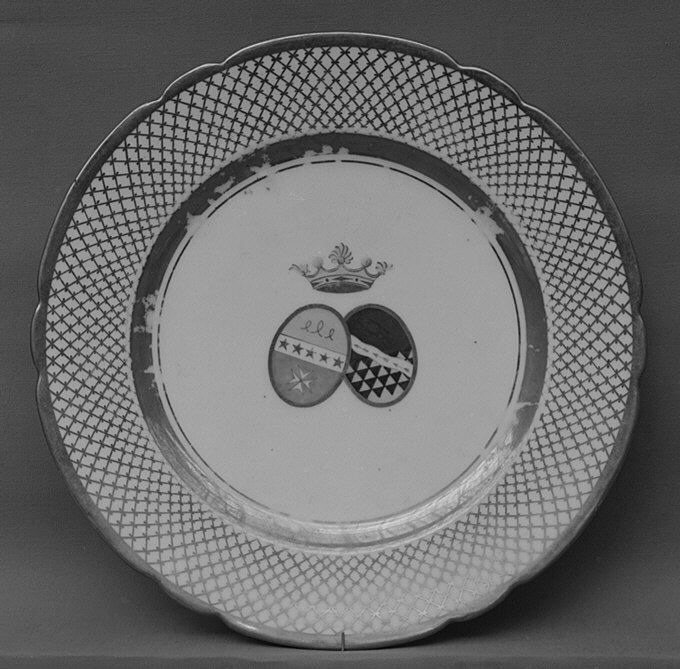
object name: plate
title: Dinner plate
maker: couderc, couderc-bucher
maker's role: maker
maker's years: 1844-1850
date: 1845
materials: hard paste porcelain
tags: coat of arms